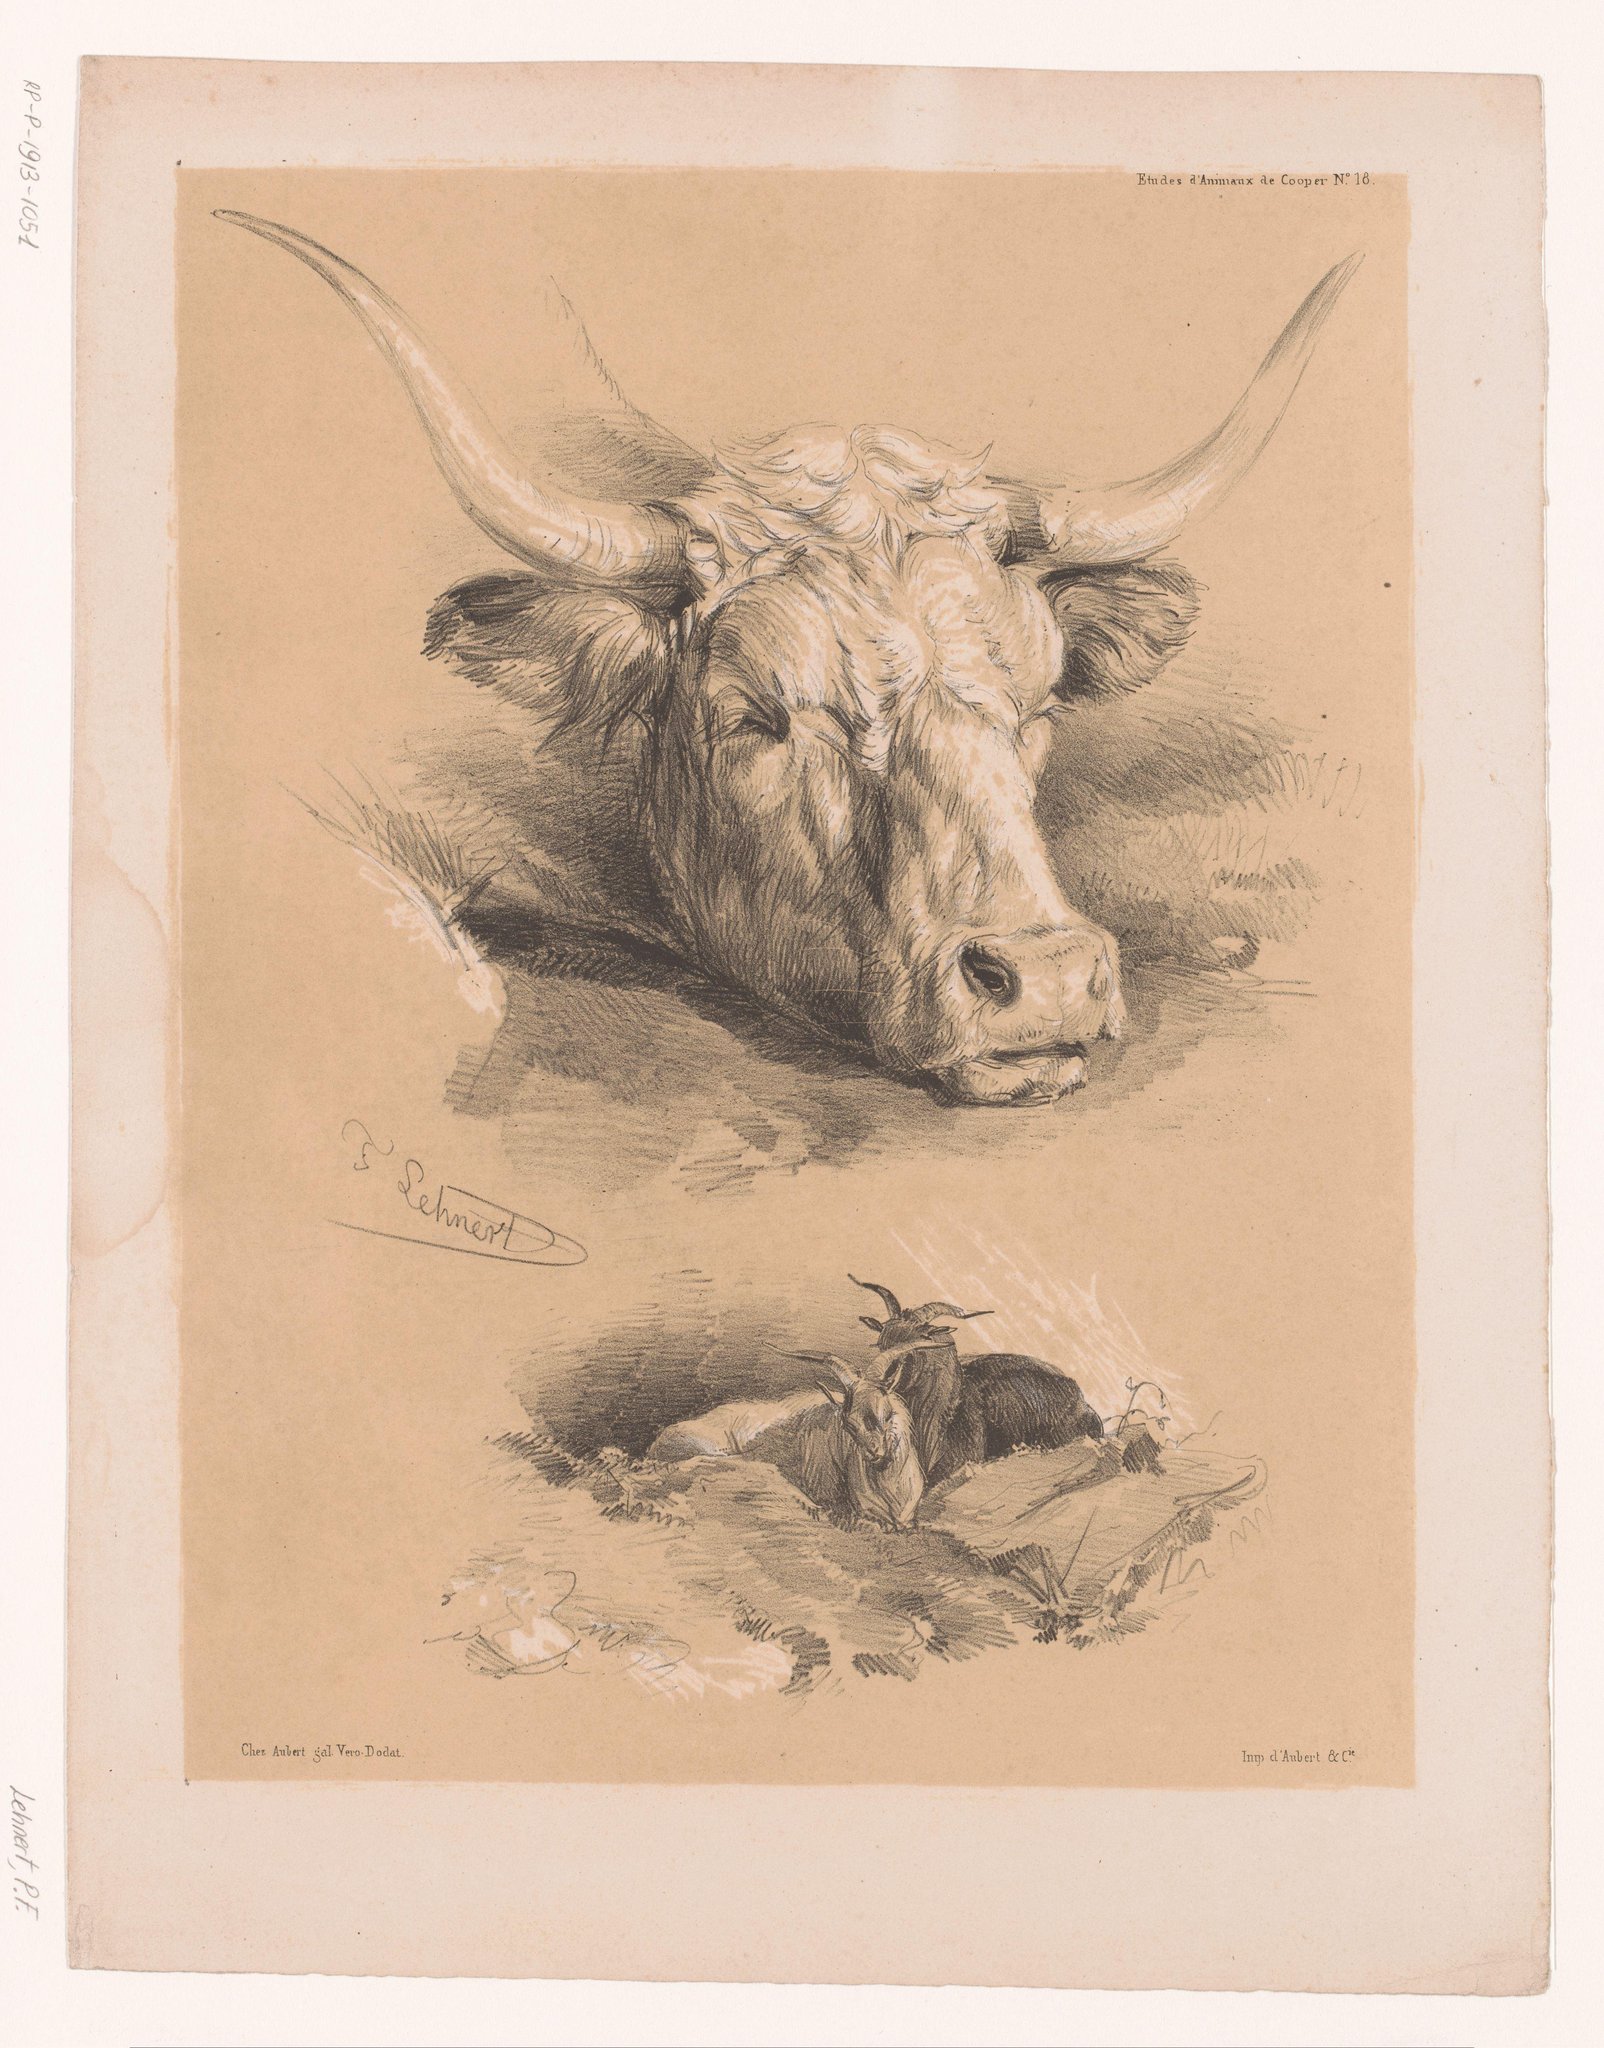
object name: print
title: Études d'Animaux de Cooper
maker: pierre frédéric lehnert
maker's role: print maker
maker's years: 1811-1880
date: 1838-1840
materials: paper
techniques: tone lithography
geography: paris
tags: bull, he-goat, billy-goat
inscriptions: collector's mark: Lugt 2228a